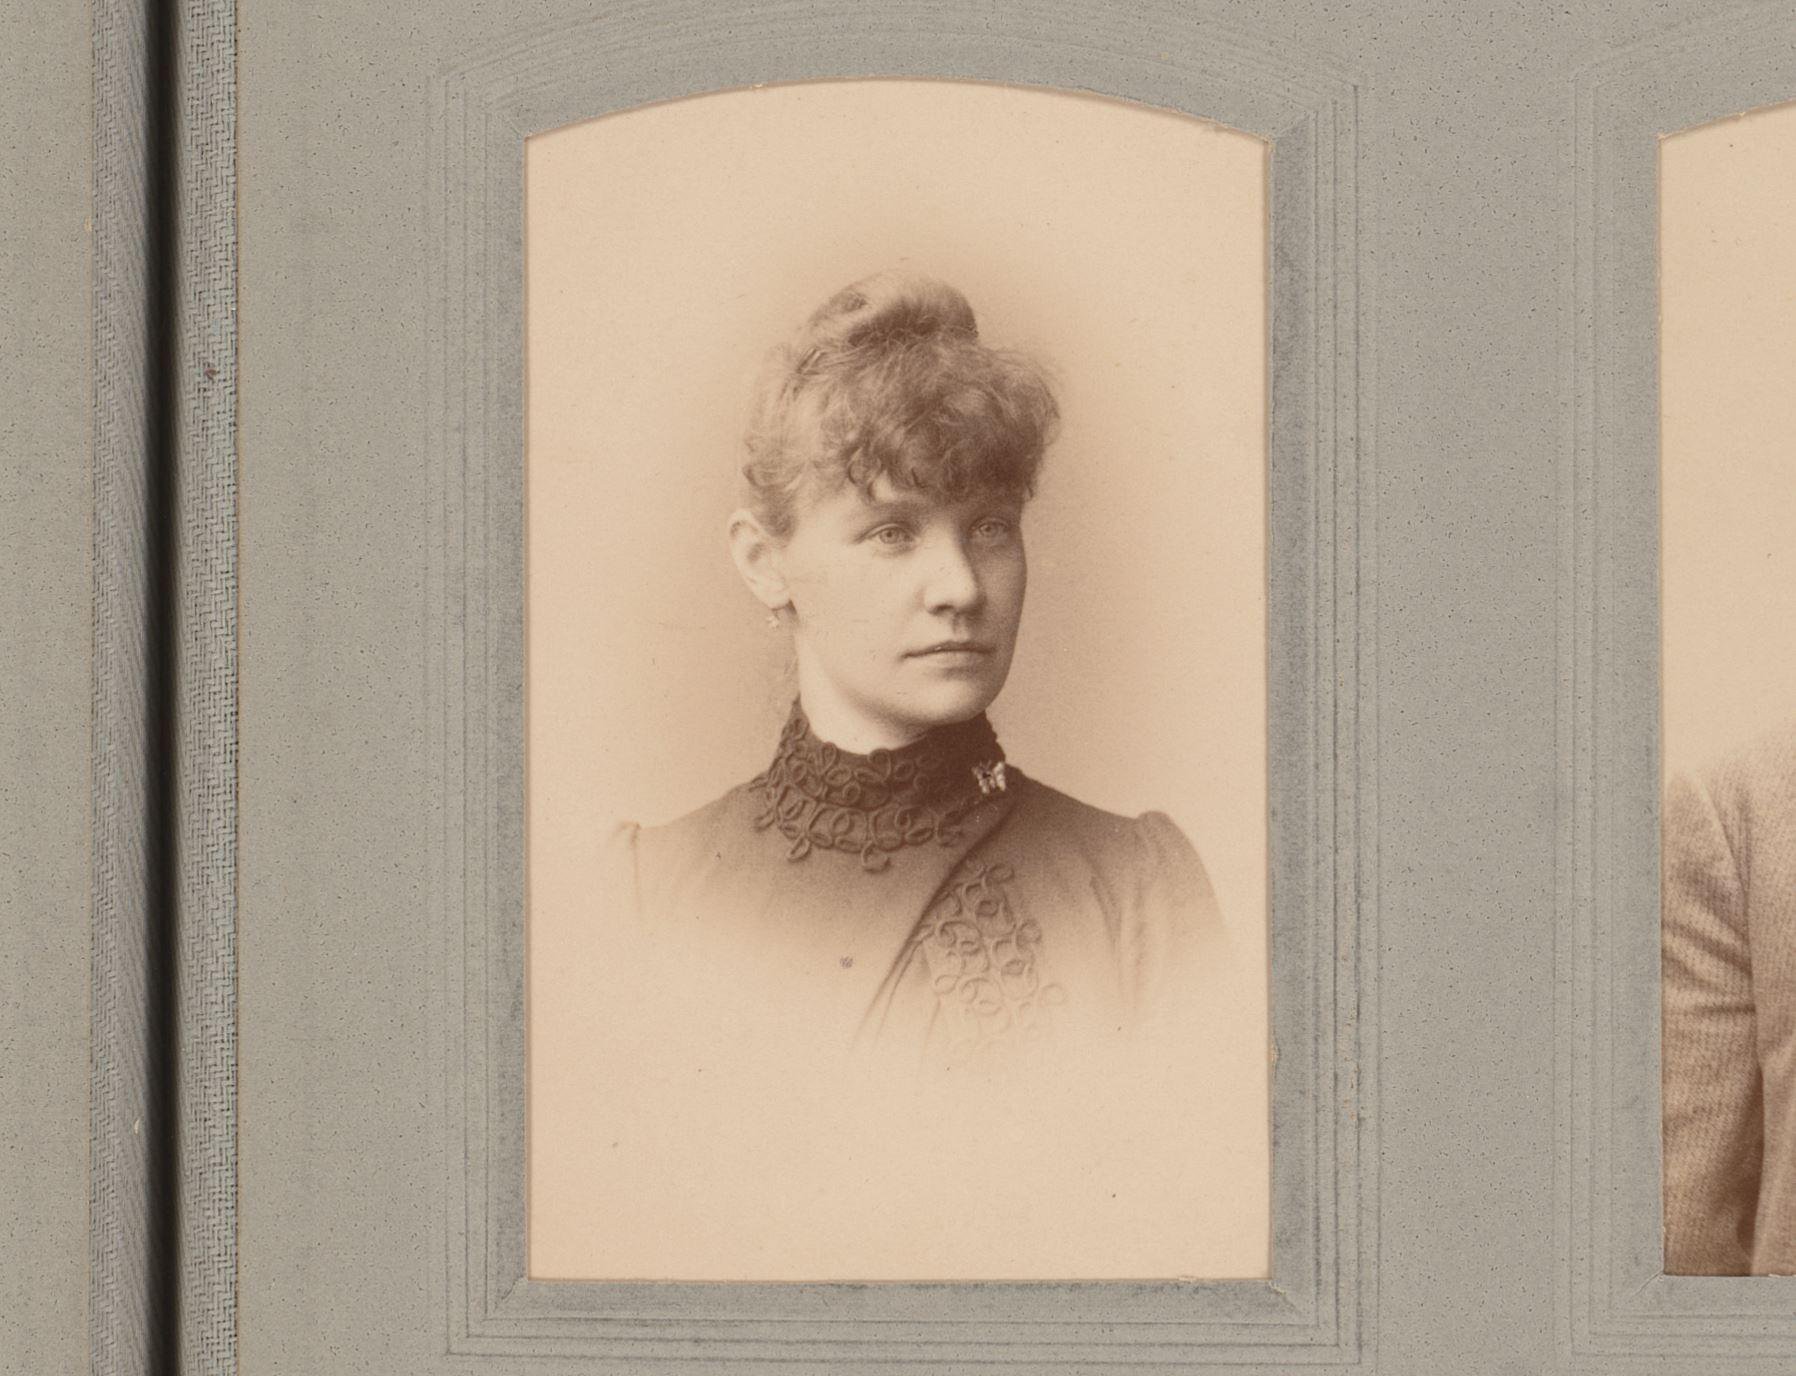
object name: carte de visite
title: Portret van een vrouw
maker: stahlberg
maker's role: fotograaf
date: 1872-1900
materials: cardboard, photographic support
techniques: albumen print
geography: helsinki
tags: historical persons - bb - woman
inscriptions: inscription: ‘K. E. Ståhlberg/ Helsinki/ 17.Aleksanterinkatu 17.’